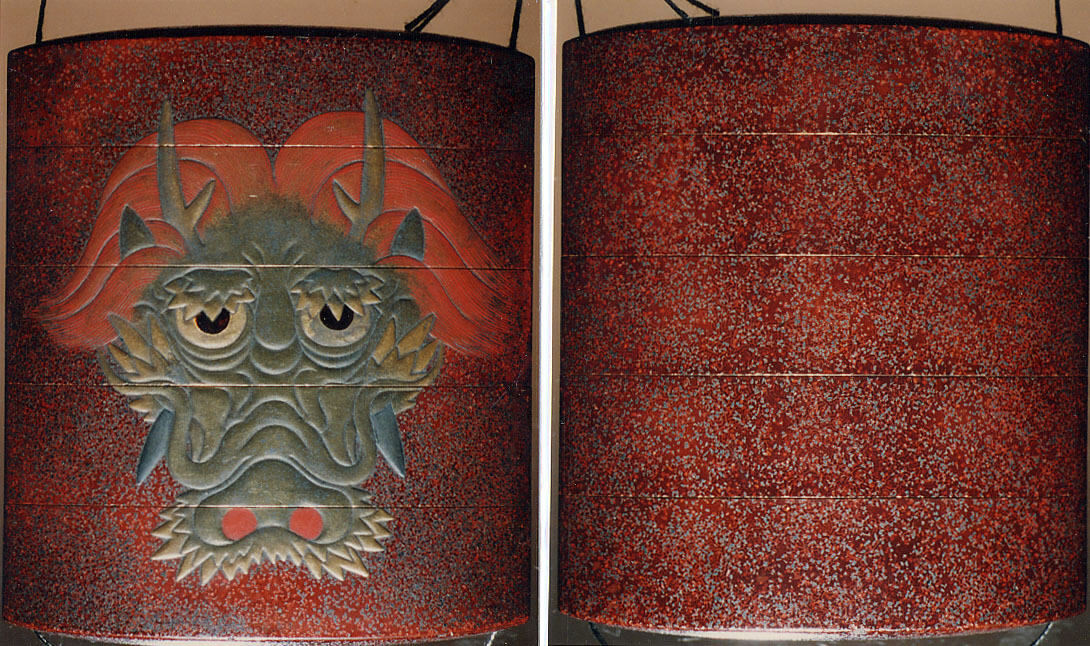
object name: inrō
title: Case (Inrō) with Design of Dragon Facing Front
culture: japanese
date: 1801-1900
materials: gold, lacquer, silver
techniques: fundame, hiramakie, inlay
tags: dragons